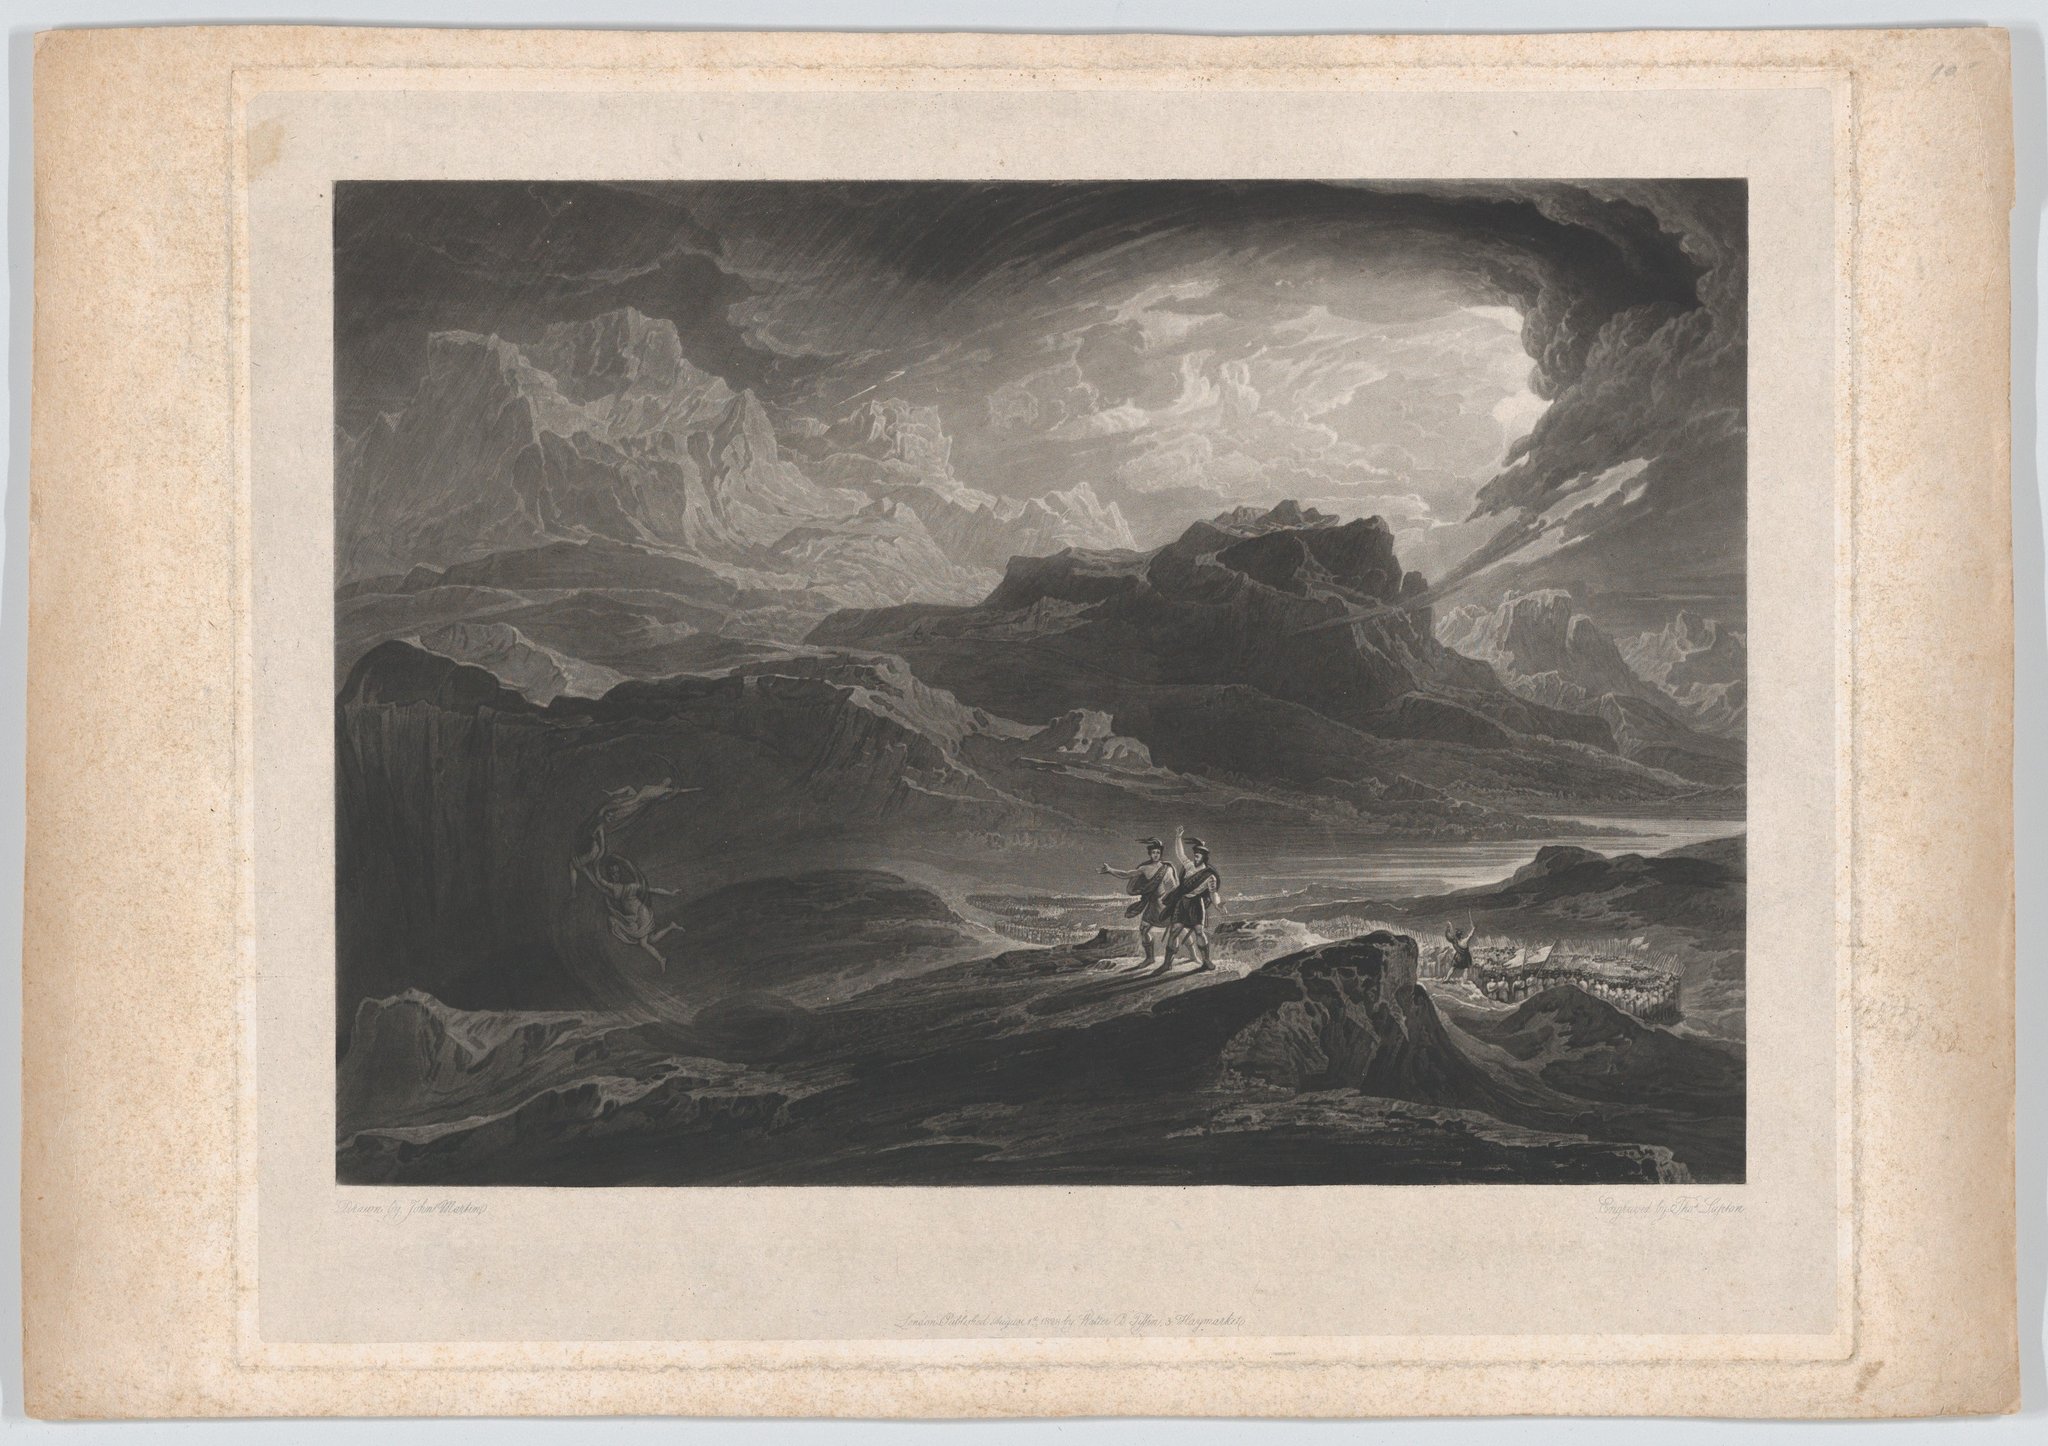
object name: print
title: Macbeth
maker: thomas goff lupton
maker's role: engraver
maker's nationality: british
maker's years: 1791-1873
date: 1828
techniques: mezzotint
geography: england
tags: human figures,mountains